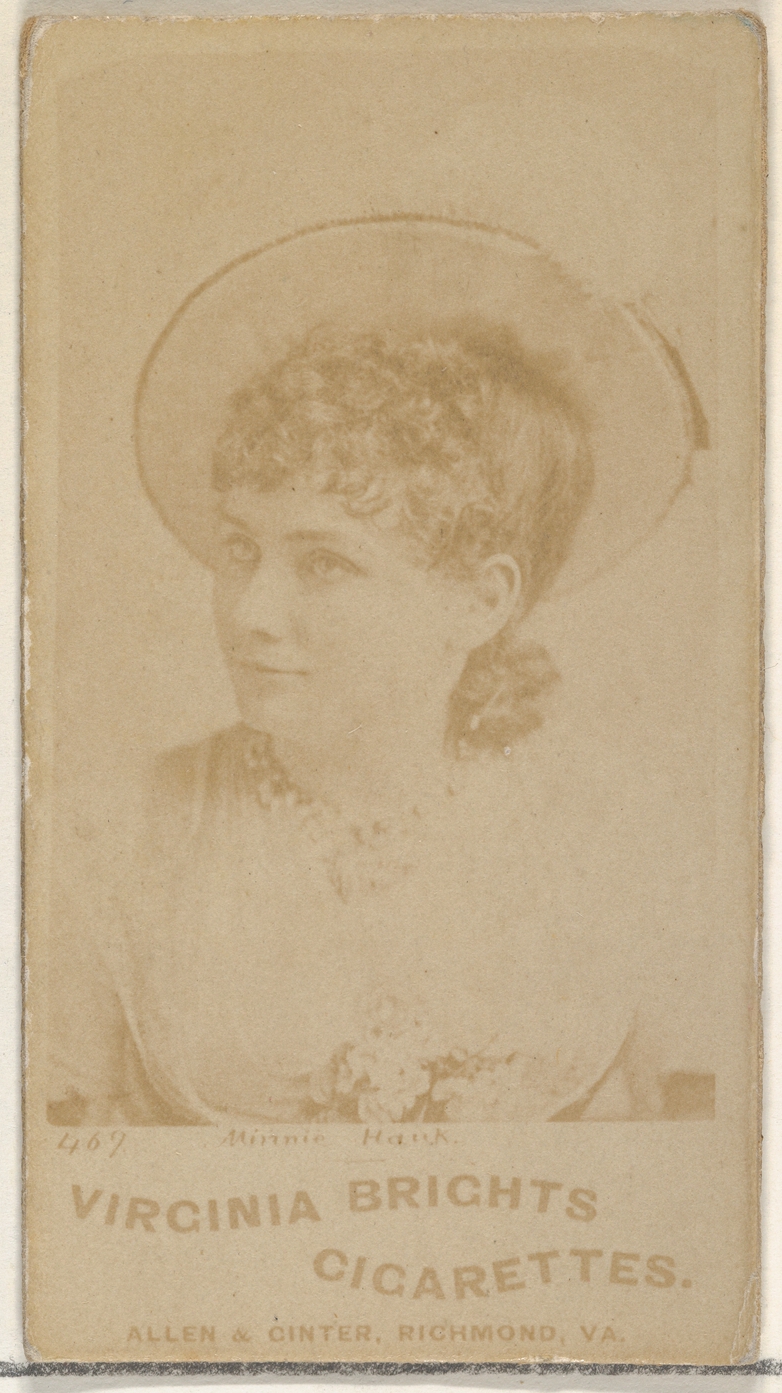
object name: photograph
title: Card 469, Minnie Hank, from the Actors and Actresses series (N45, Type 1) for Virginia Brights Cigarettes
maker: allen & ginter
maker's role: publisher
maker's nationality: american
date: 1888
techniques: albumen silver print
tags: portraits,women,actresses